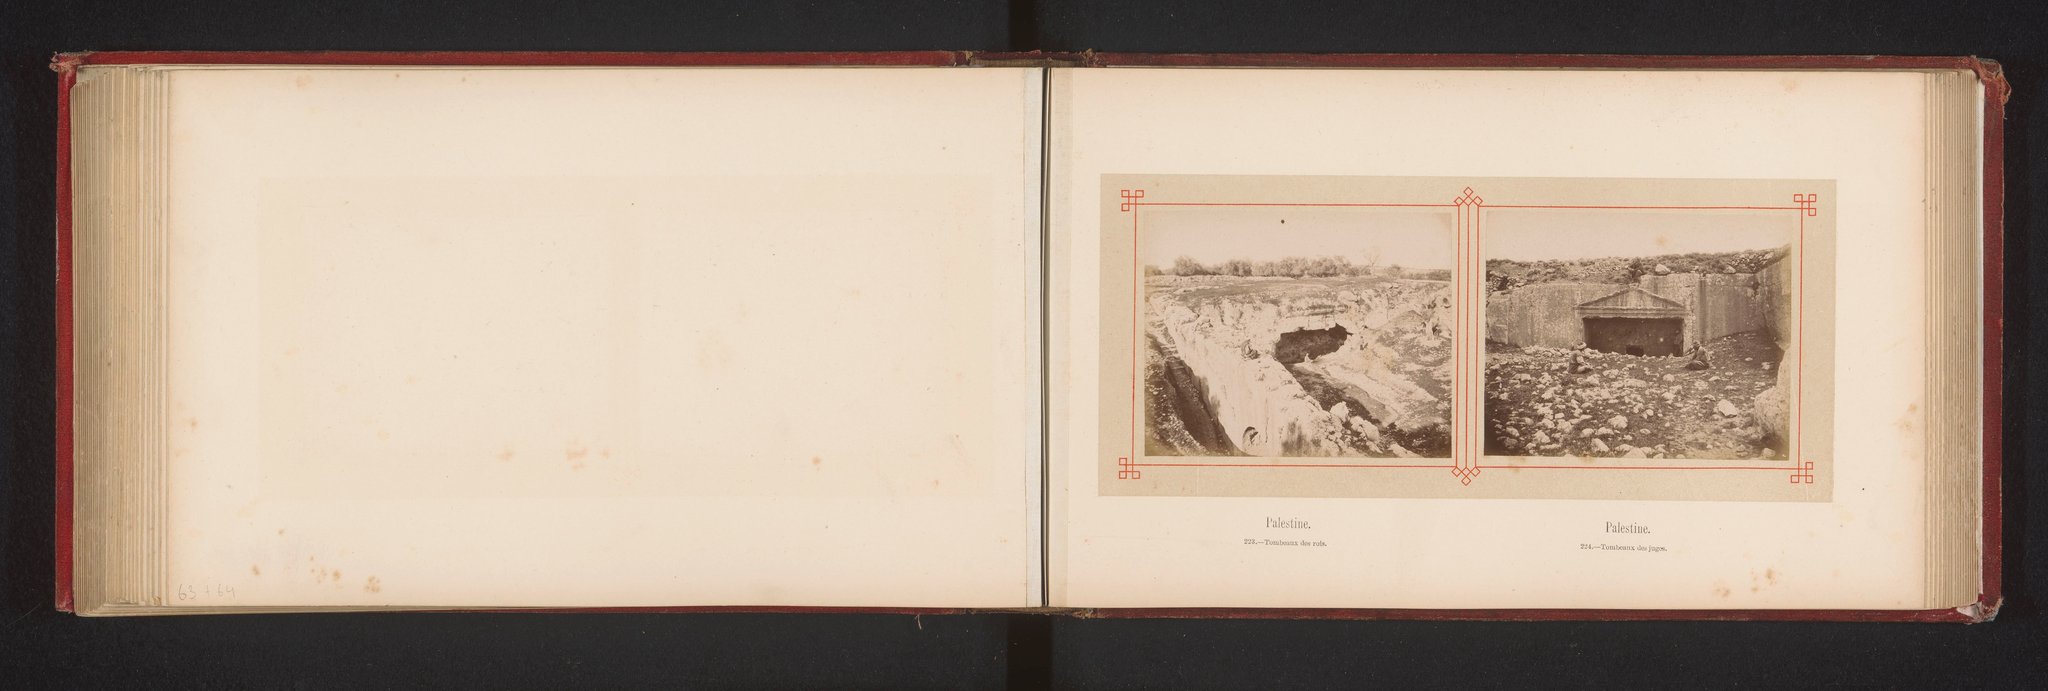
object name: page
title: Drie onbekende mannen bij de tombes van de rechters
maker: félix bonfils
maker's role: fotograaf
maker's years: 1831-1885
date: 1873-1878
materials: photographic support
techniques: albumen print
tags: landscapes, grave, tomb